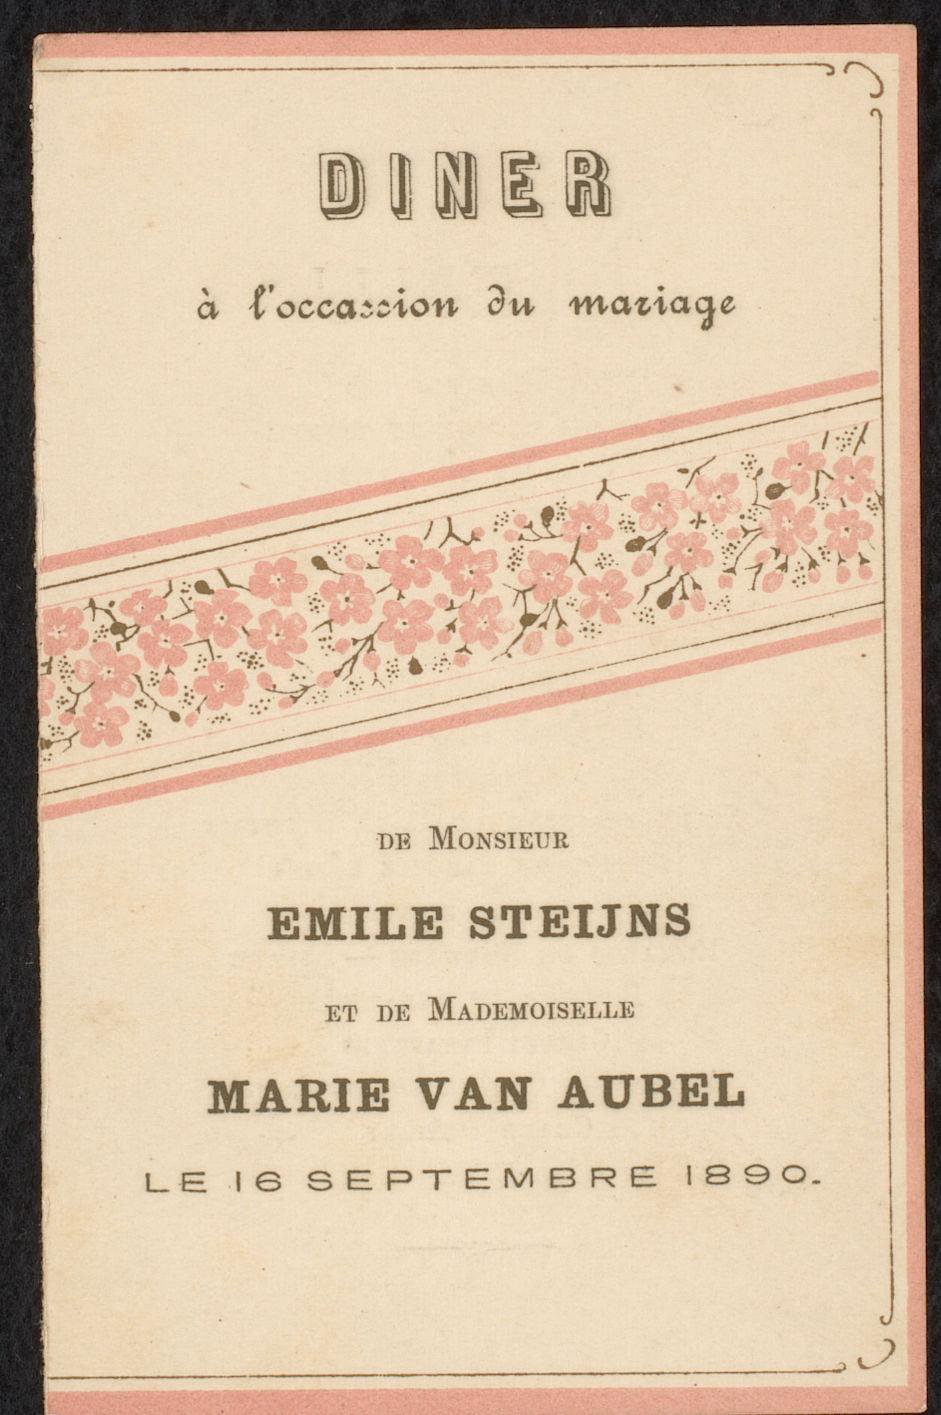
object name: print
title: Menu van het diner ter ere van het huwelijk van Emile Steyns met Marie van Aubel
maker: Anonymous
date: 1890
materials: paper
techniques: letterpress printing, lithograph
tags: flowers, first communion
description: Op de voorzijde een band van bloemetjes tussen twee blokken tekst met de namen van het echtpaar en de datum van het huwelijk (16 september 1890). Op de achterzijde het menu van het diner.